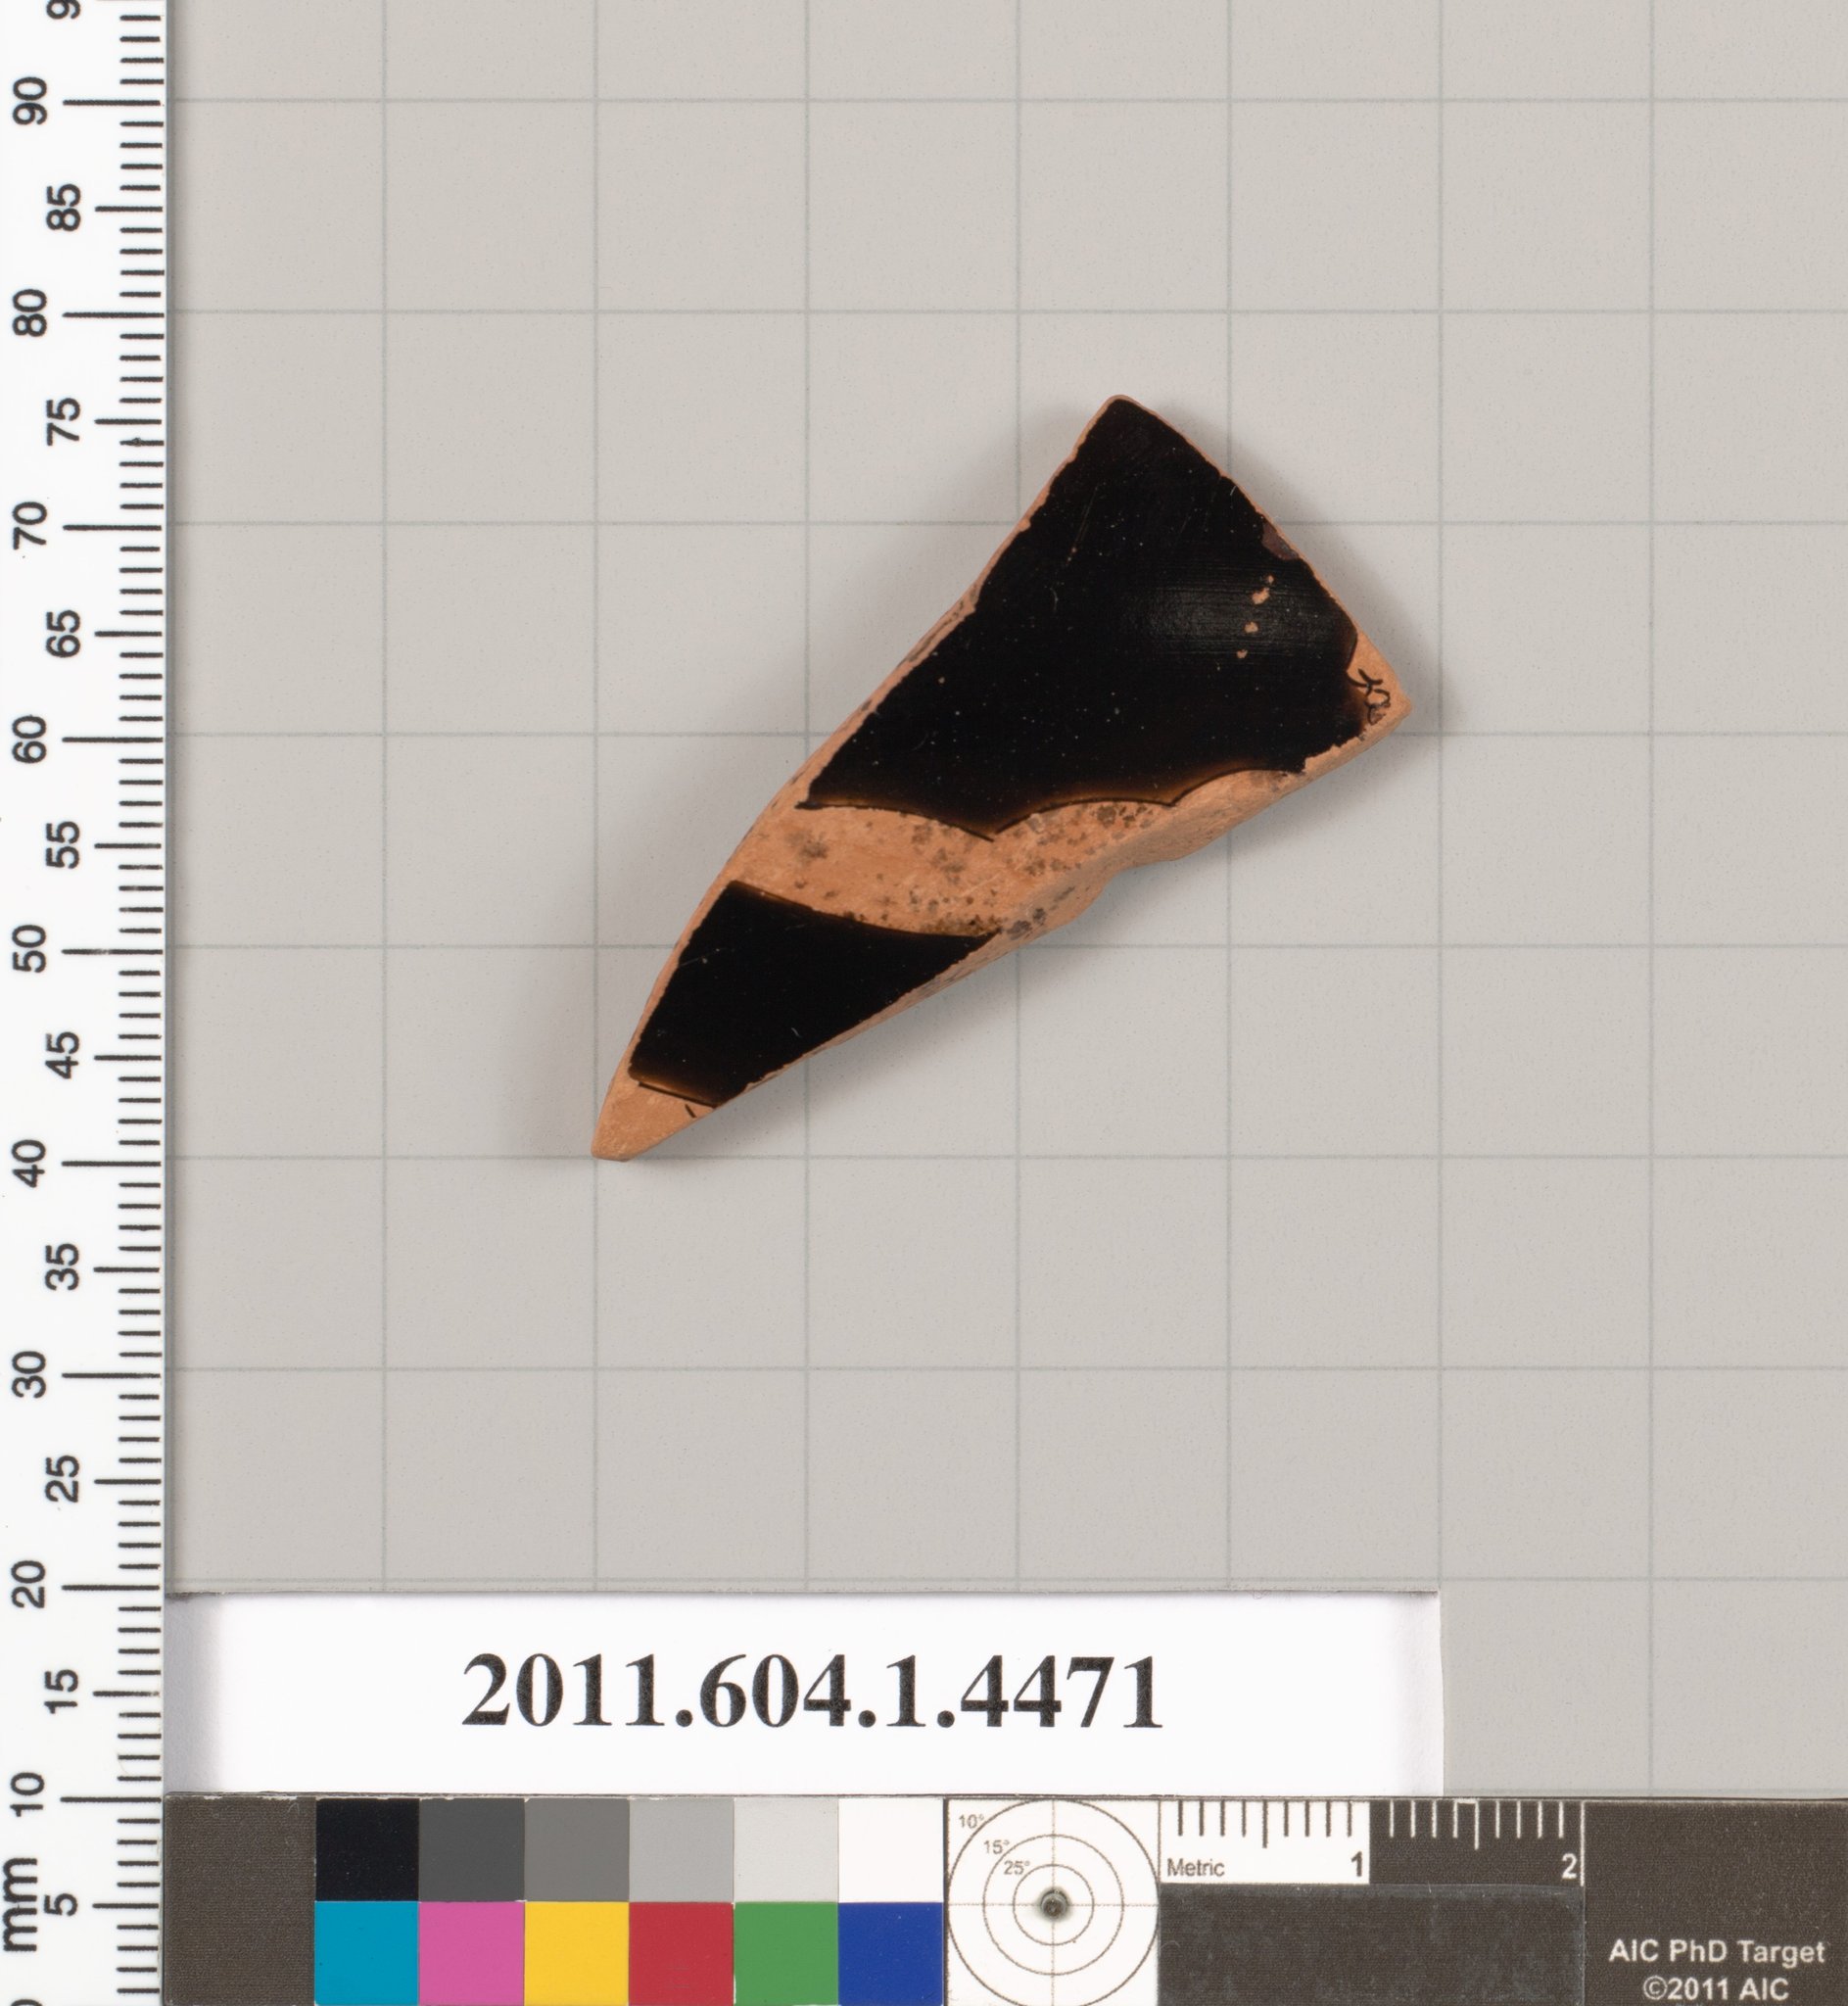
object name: kylix fragment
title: Terracotta fragment of a kylix (drinking cup)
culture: greek, attic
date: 480-470 BCE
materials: terracotta